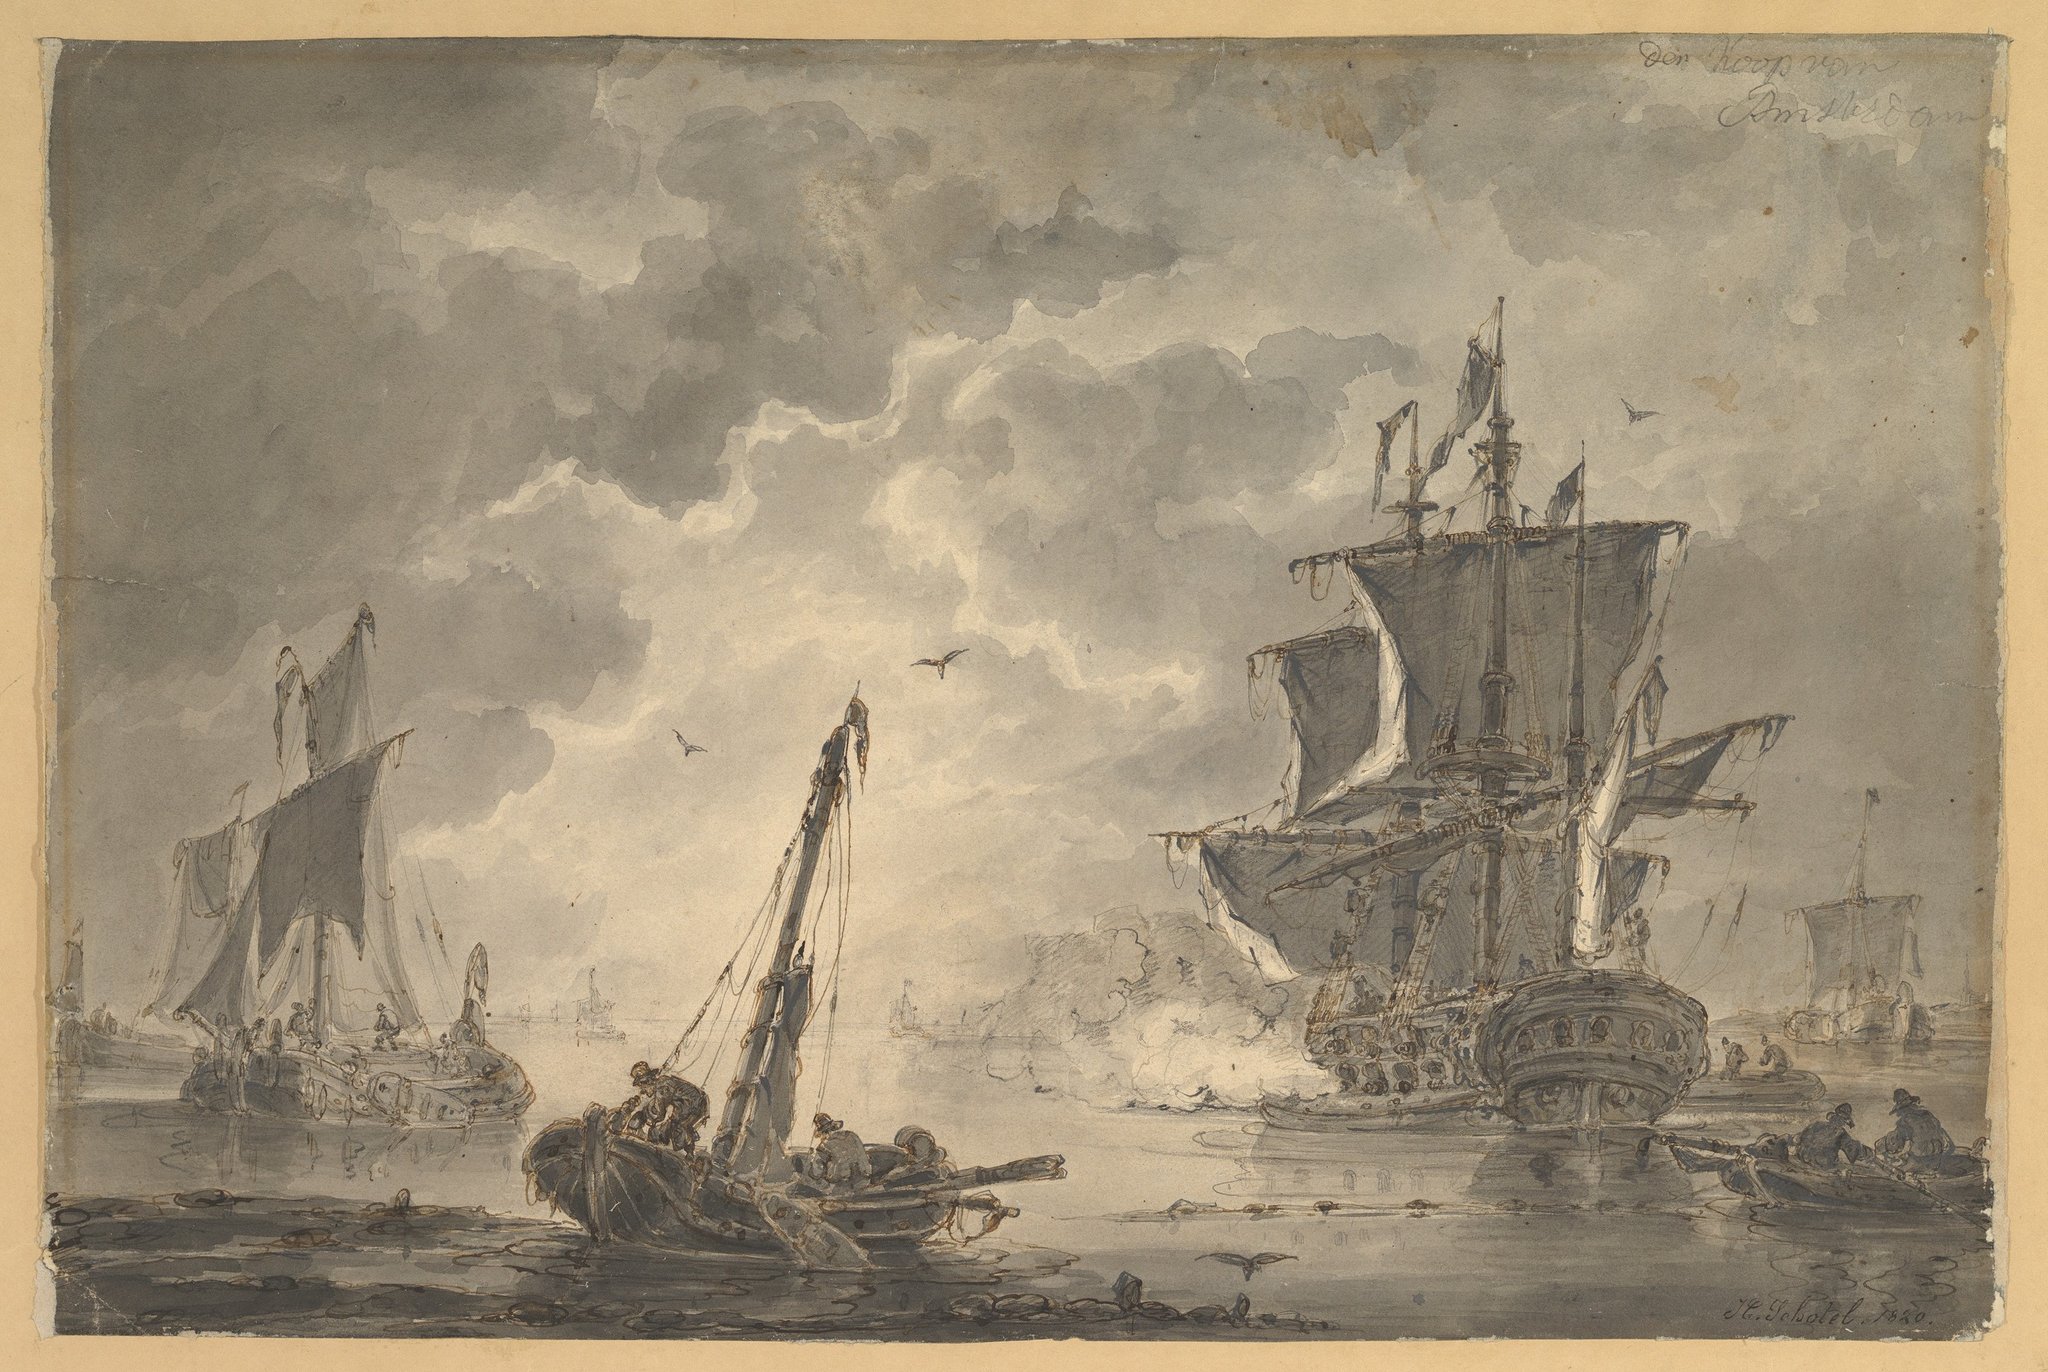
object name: drawing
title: Marine, the Cannon Shot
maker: johannes christiaan schotel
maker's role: artist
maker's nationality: dutch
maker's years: 1787-1838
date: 1787-1838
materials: graphite, ink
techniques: brush, pen, wash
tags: boats,ships